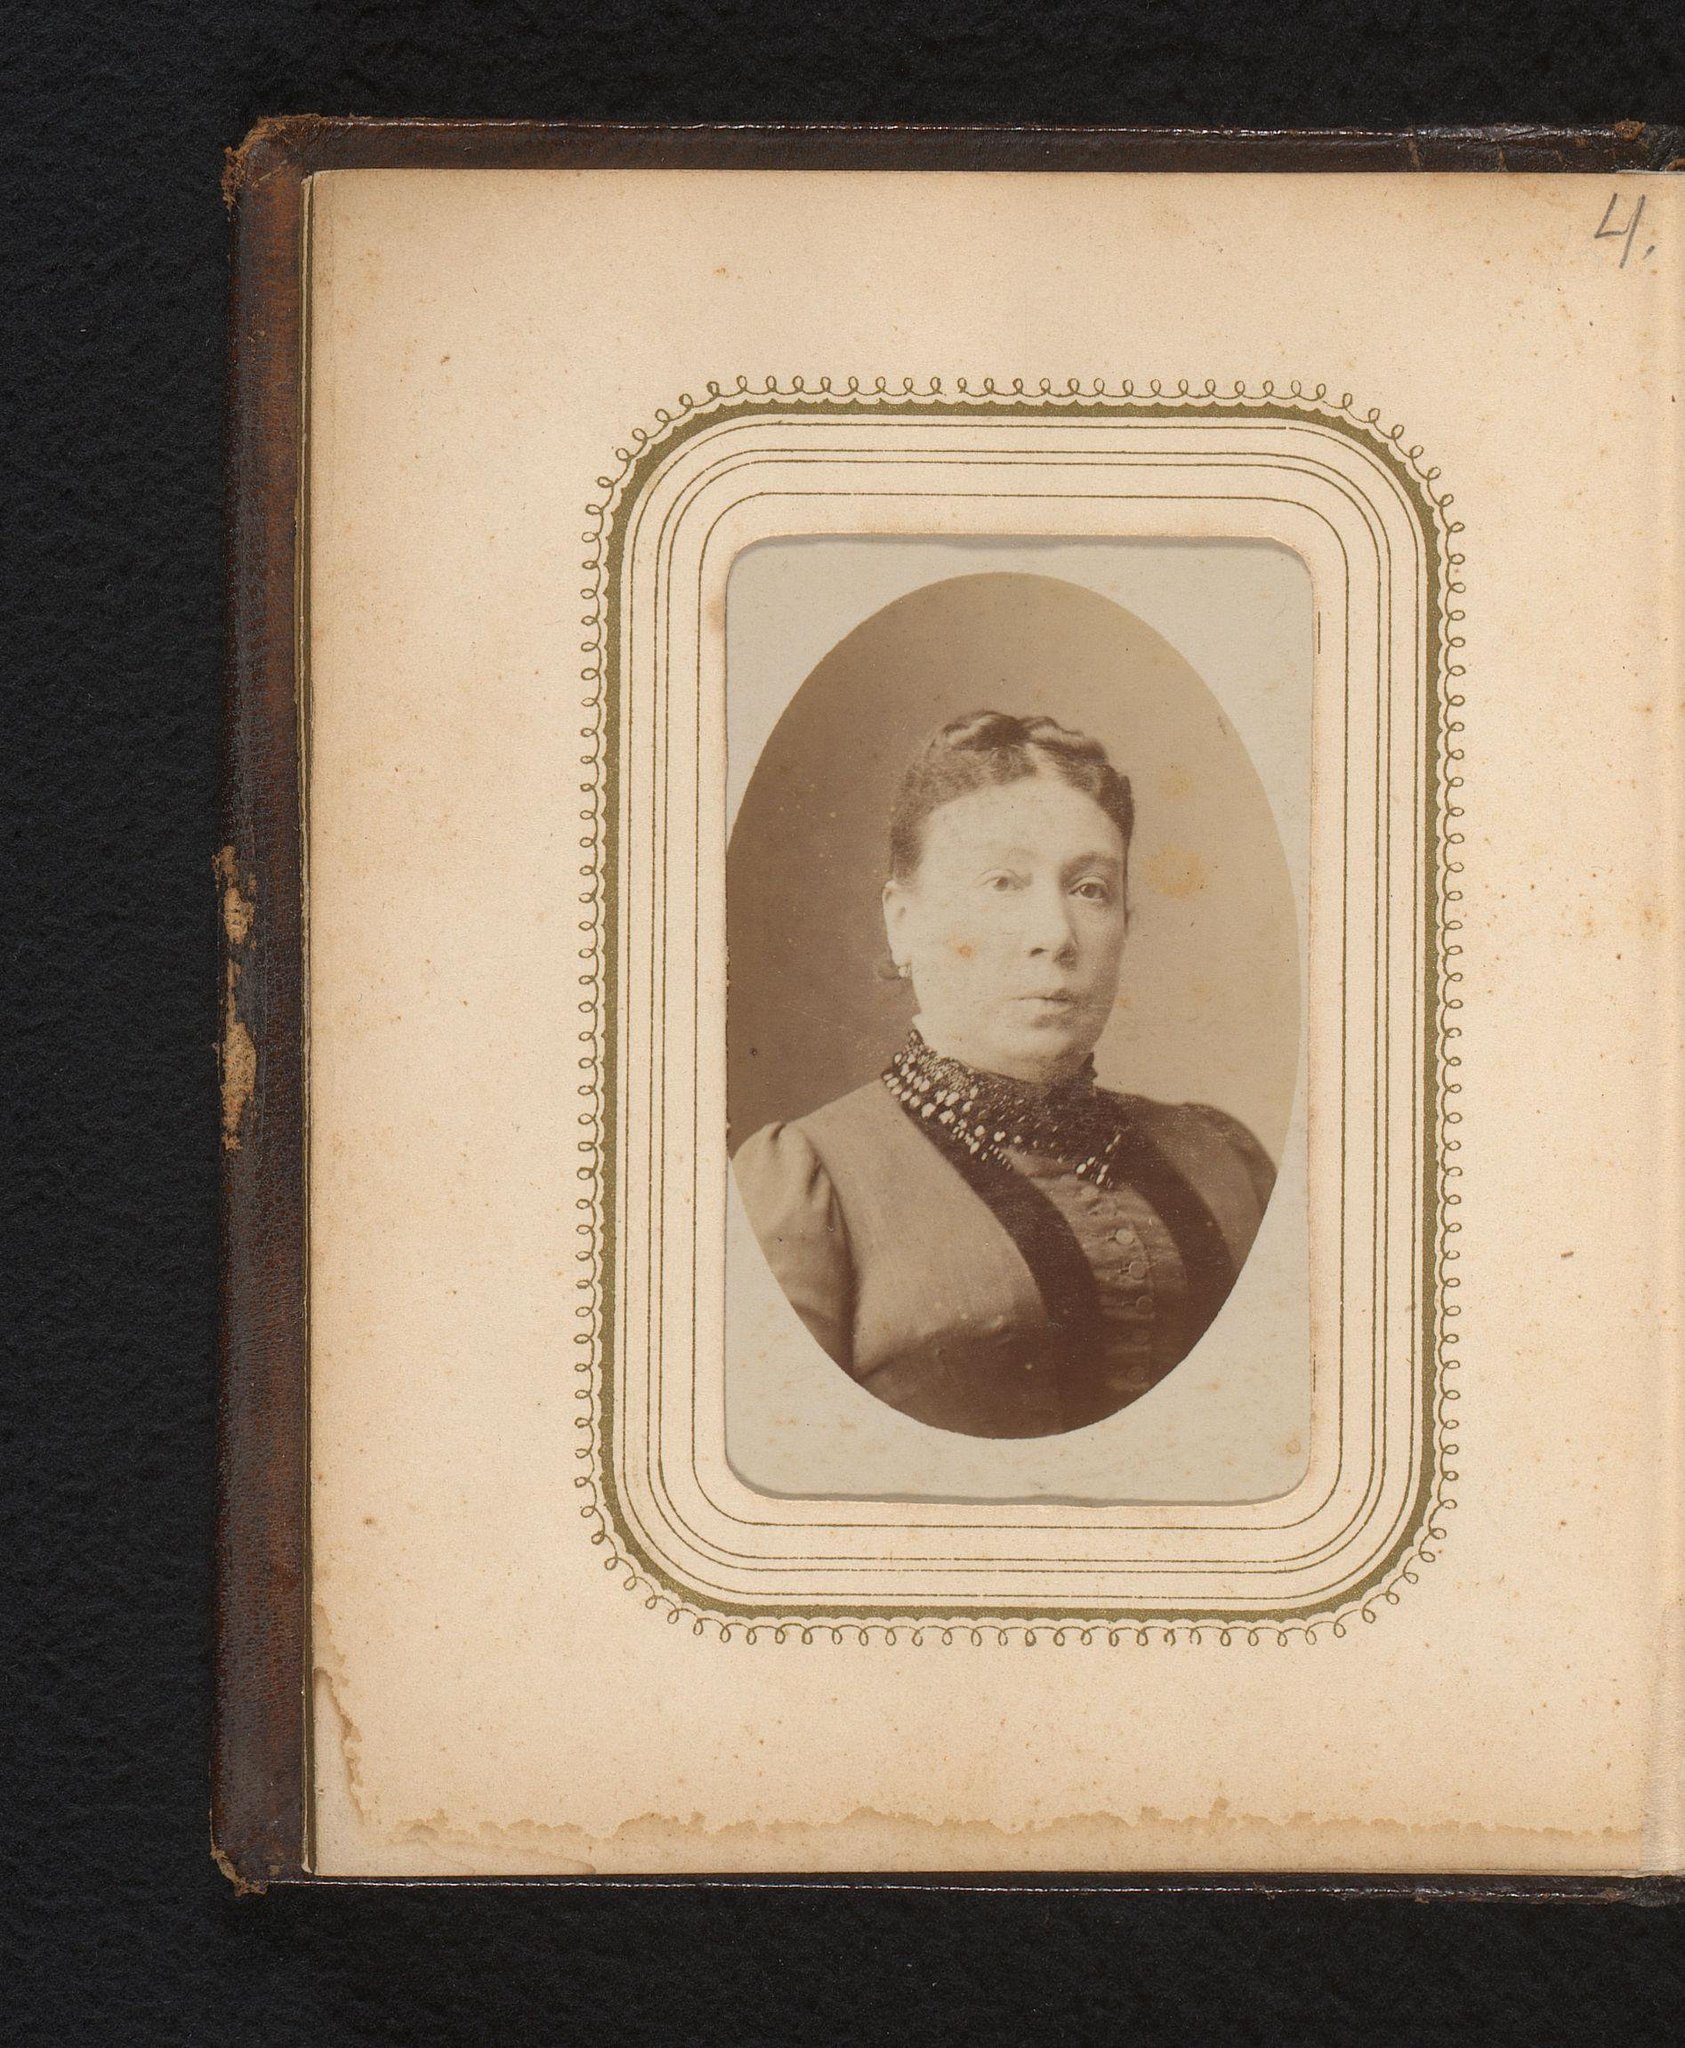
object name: carte de visite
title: Portret van Wilhelmina Mossel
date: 1875-1885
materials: cardboard, paper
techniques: albumen print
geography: amsterdam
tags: utrecht, historical persons - bb - woman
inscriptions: inscription: ‘Photographisch Artistisch Atelier/ van/ Wegner & Mottu/ Rokin over de Bank 138./ Amsterdam’